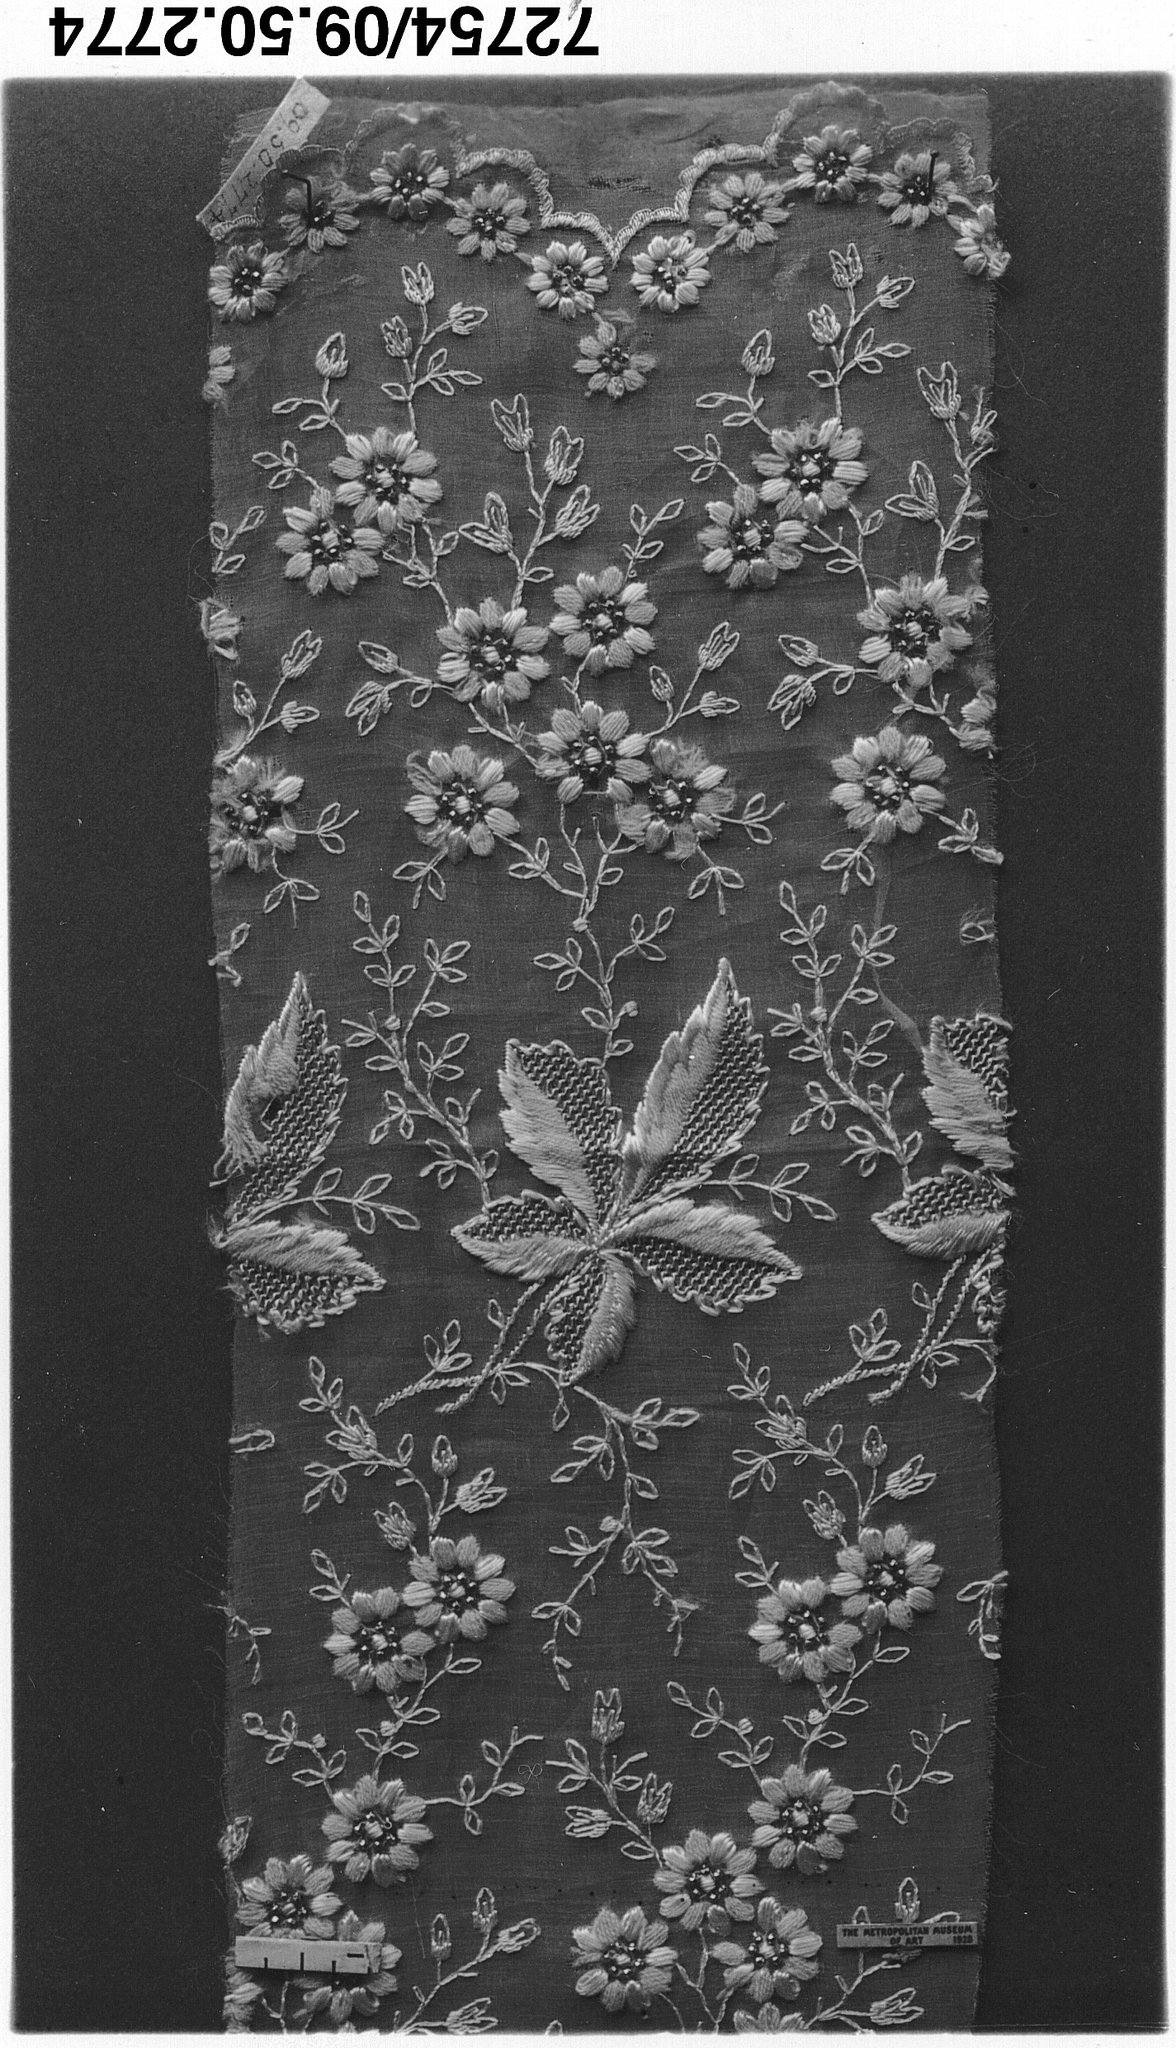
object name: fragment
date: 1801-1900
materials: silk, wool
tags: flowers,leaves